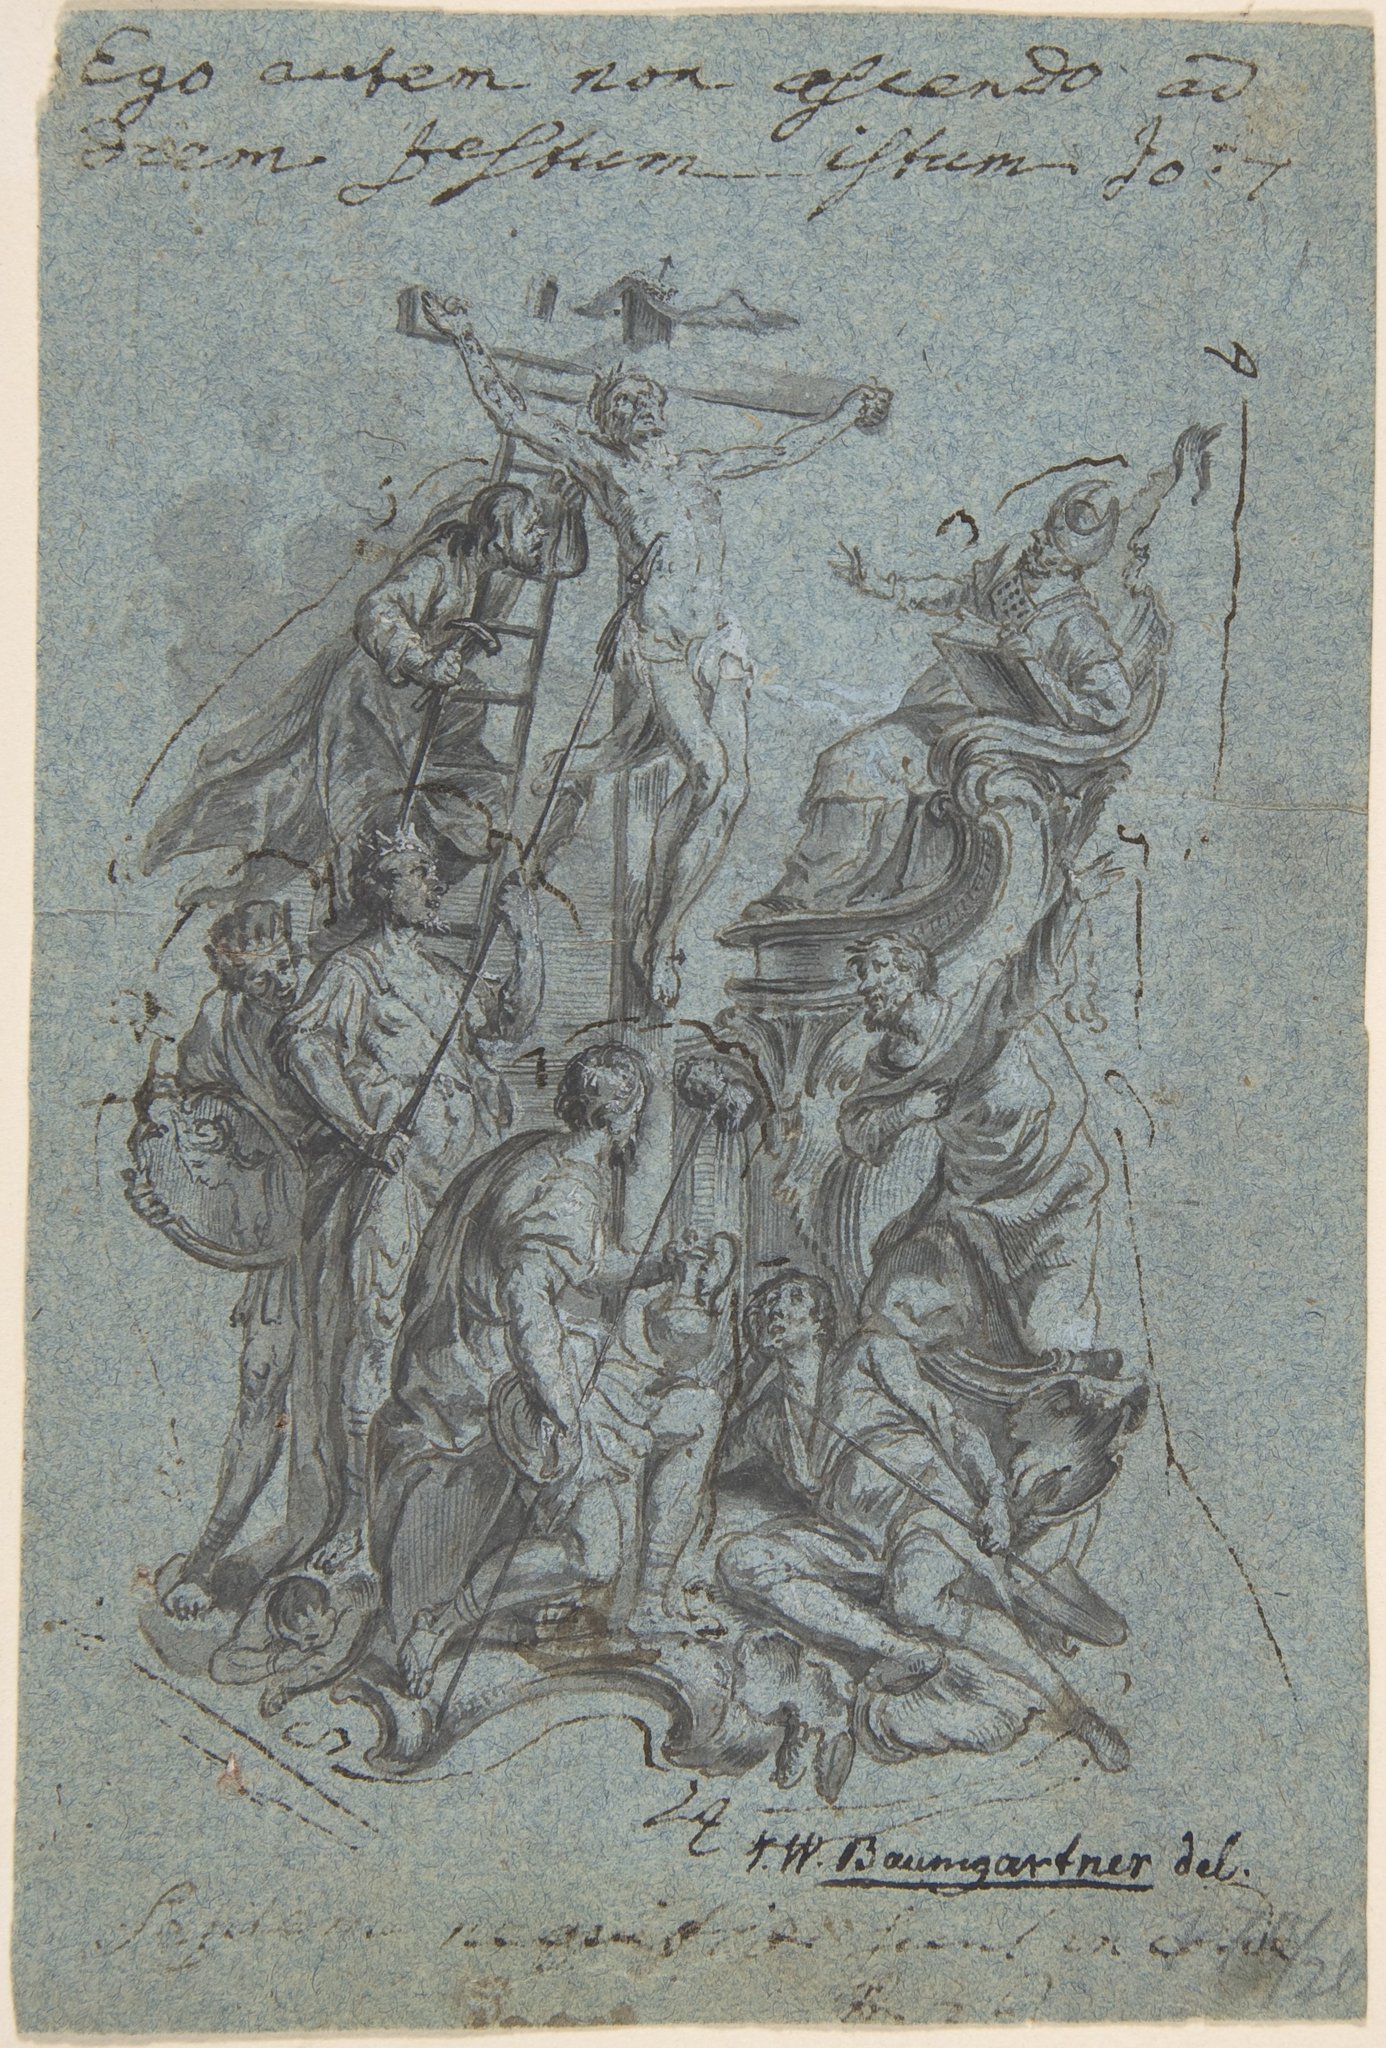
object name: drawing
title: Crucifixion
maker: johann wolfgang baumgartner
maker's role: artist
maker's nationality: german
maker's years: 1712-1761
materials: chalk, ink, paper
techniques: brush, heightening, incising, pen, transfer, wash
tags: christ,crucifixion